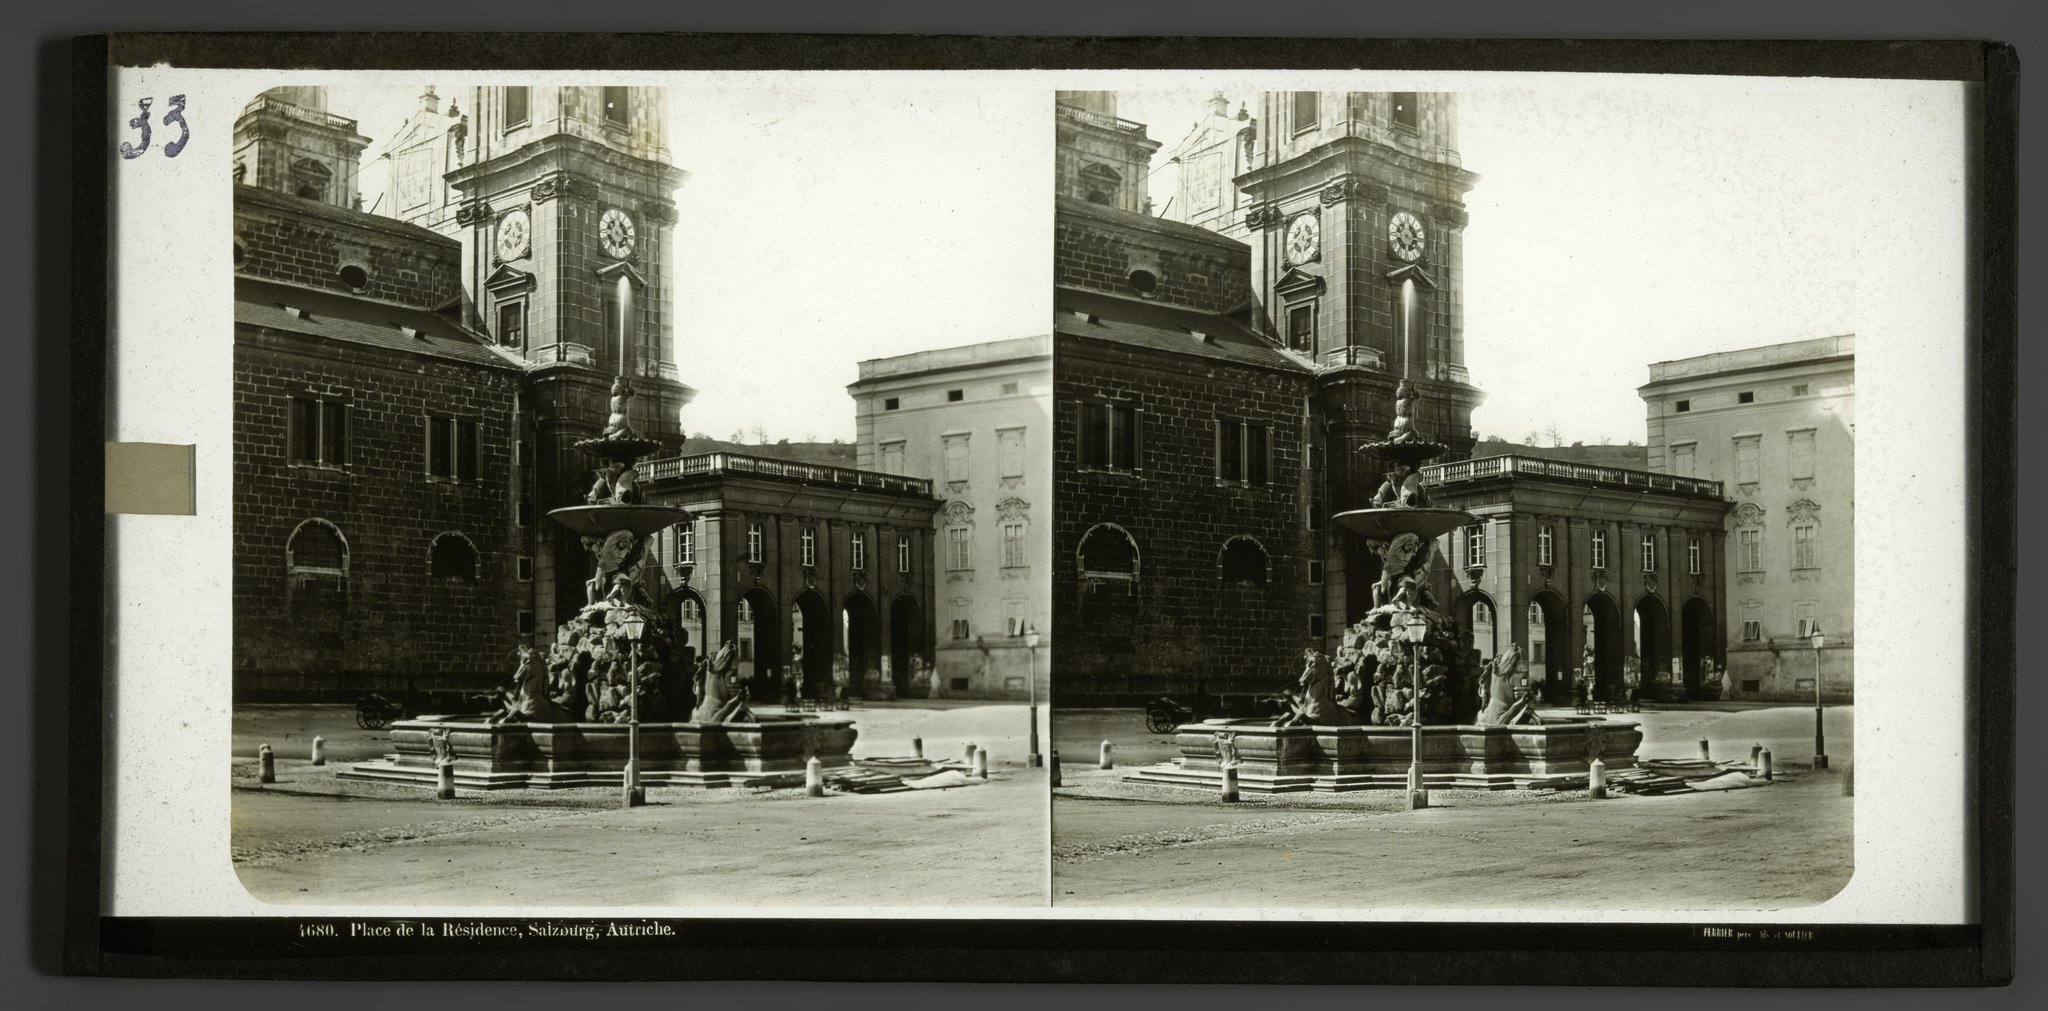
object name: stereoscopic photograph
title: Gezicht op het Residenzplatz te Salzburg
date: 1860-1870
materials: glass, paper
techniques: slide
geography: salzburg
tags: square, place, circus, etc.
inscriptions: annotation: ‘4680 Place de la Résidence, Salzburg, Autriche’, number: ‘33’